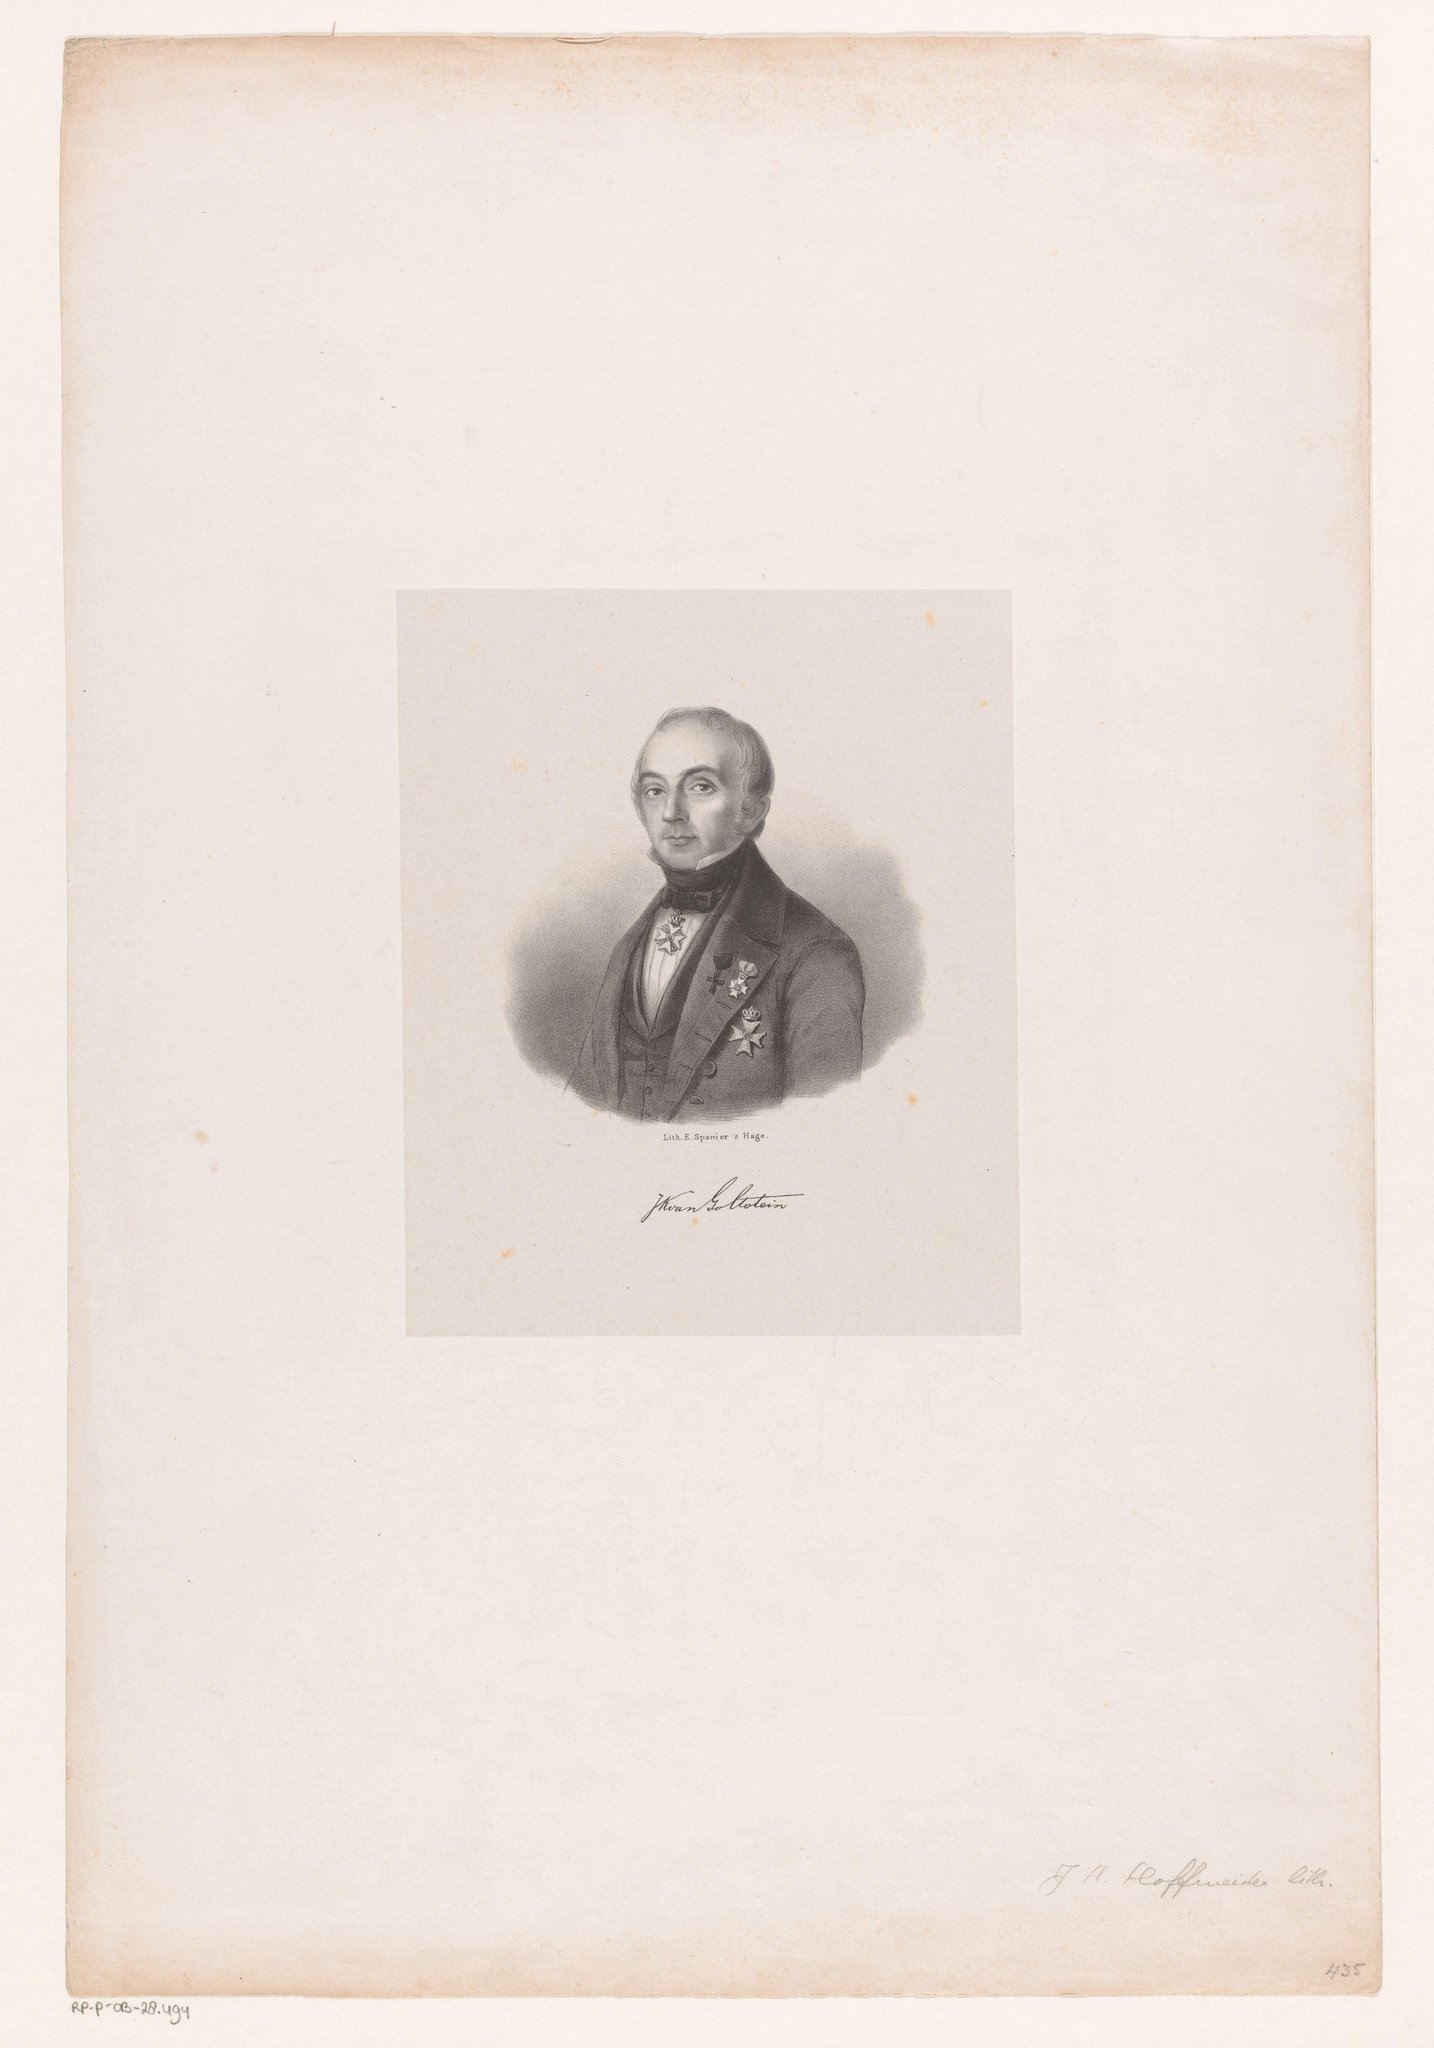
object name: print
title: Portret van Jan Carel van Goltstein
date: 1843-1863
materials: paper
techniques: lithograph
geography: netherlands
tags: arnhem, the hague, politician, knighthood order, historical persons (+ (full) bust portrait)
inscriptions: collector's mark: Lugt 2228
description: Hij draagt drie ridderorden op zijn jas en een aan zijn das. Onder het portret zijn signatuur.